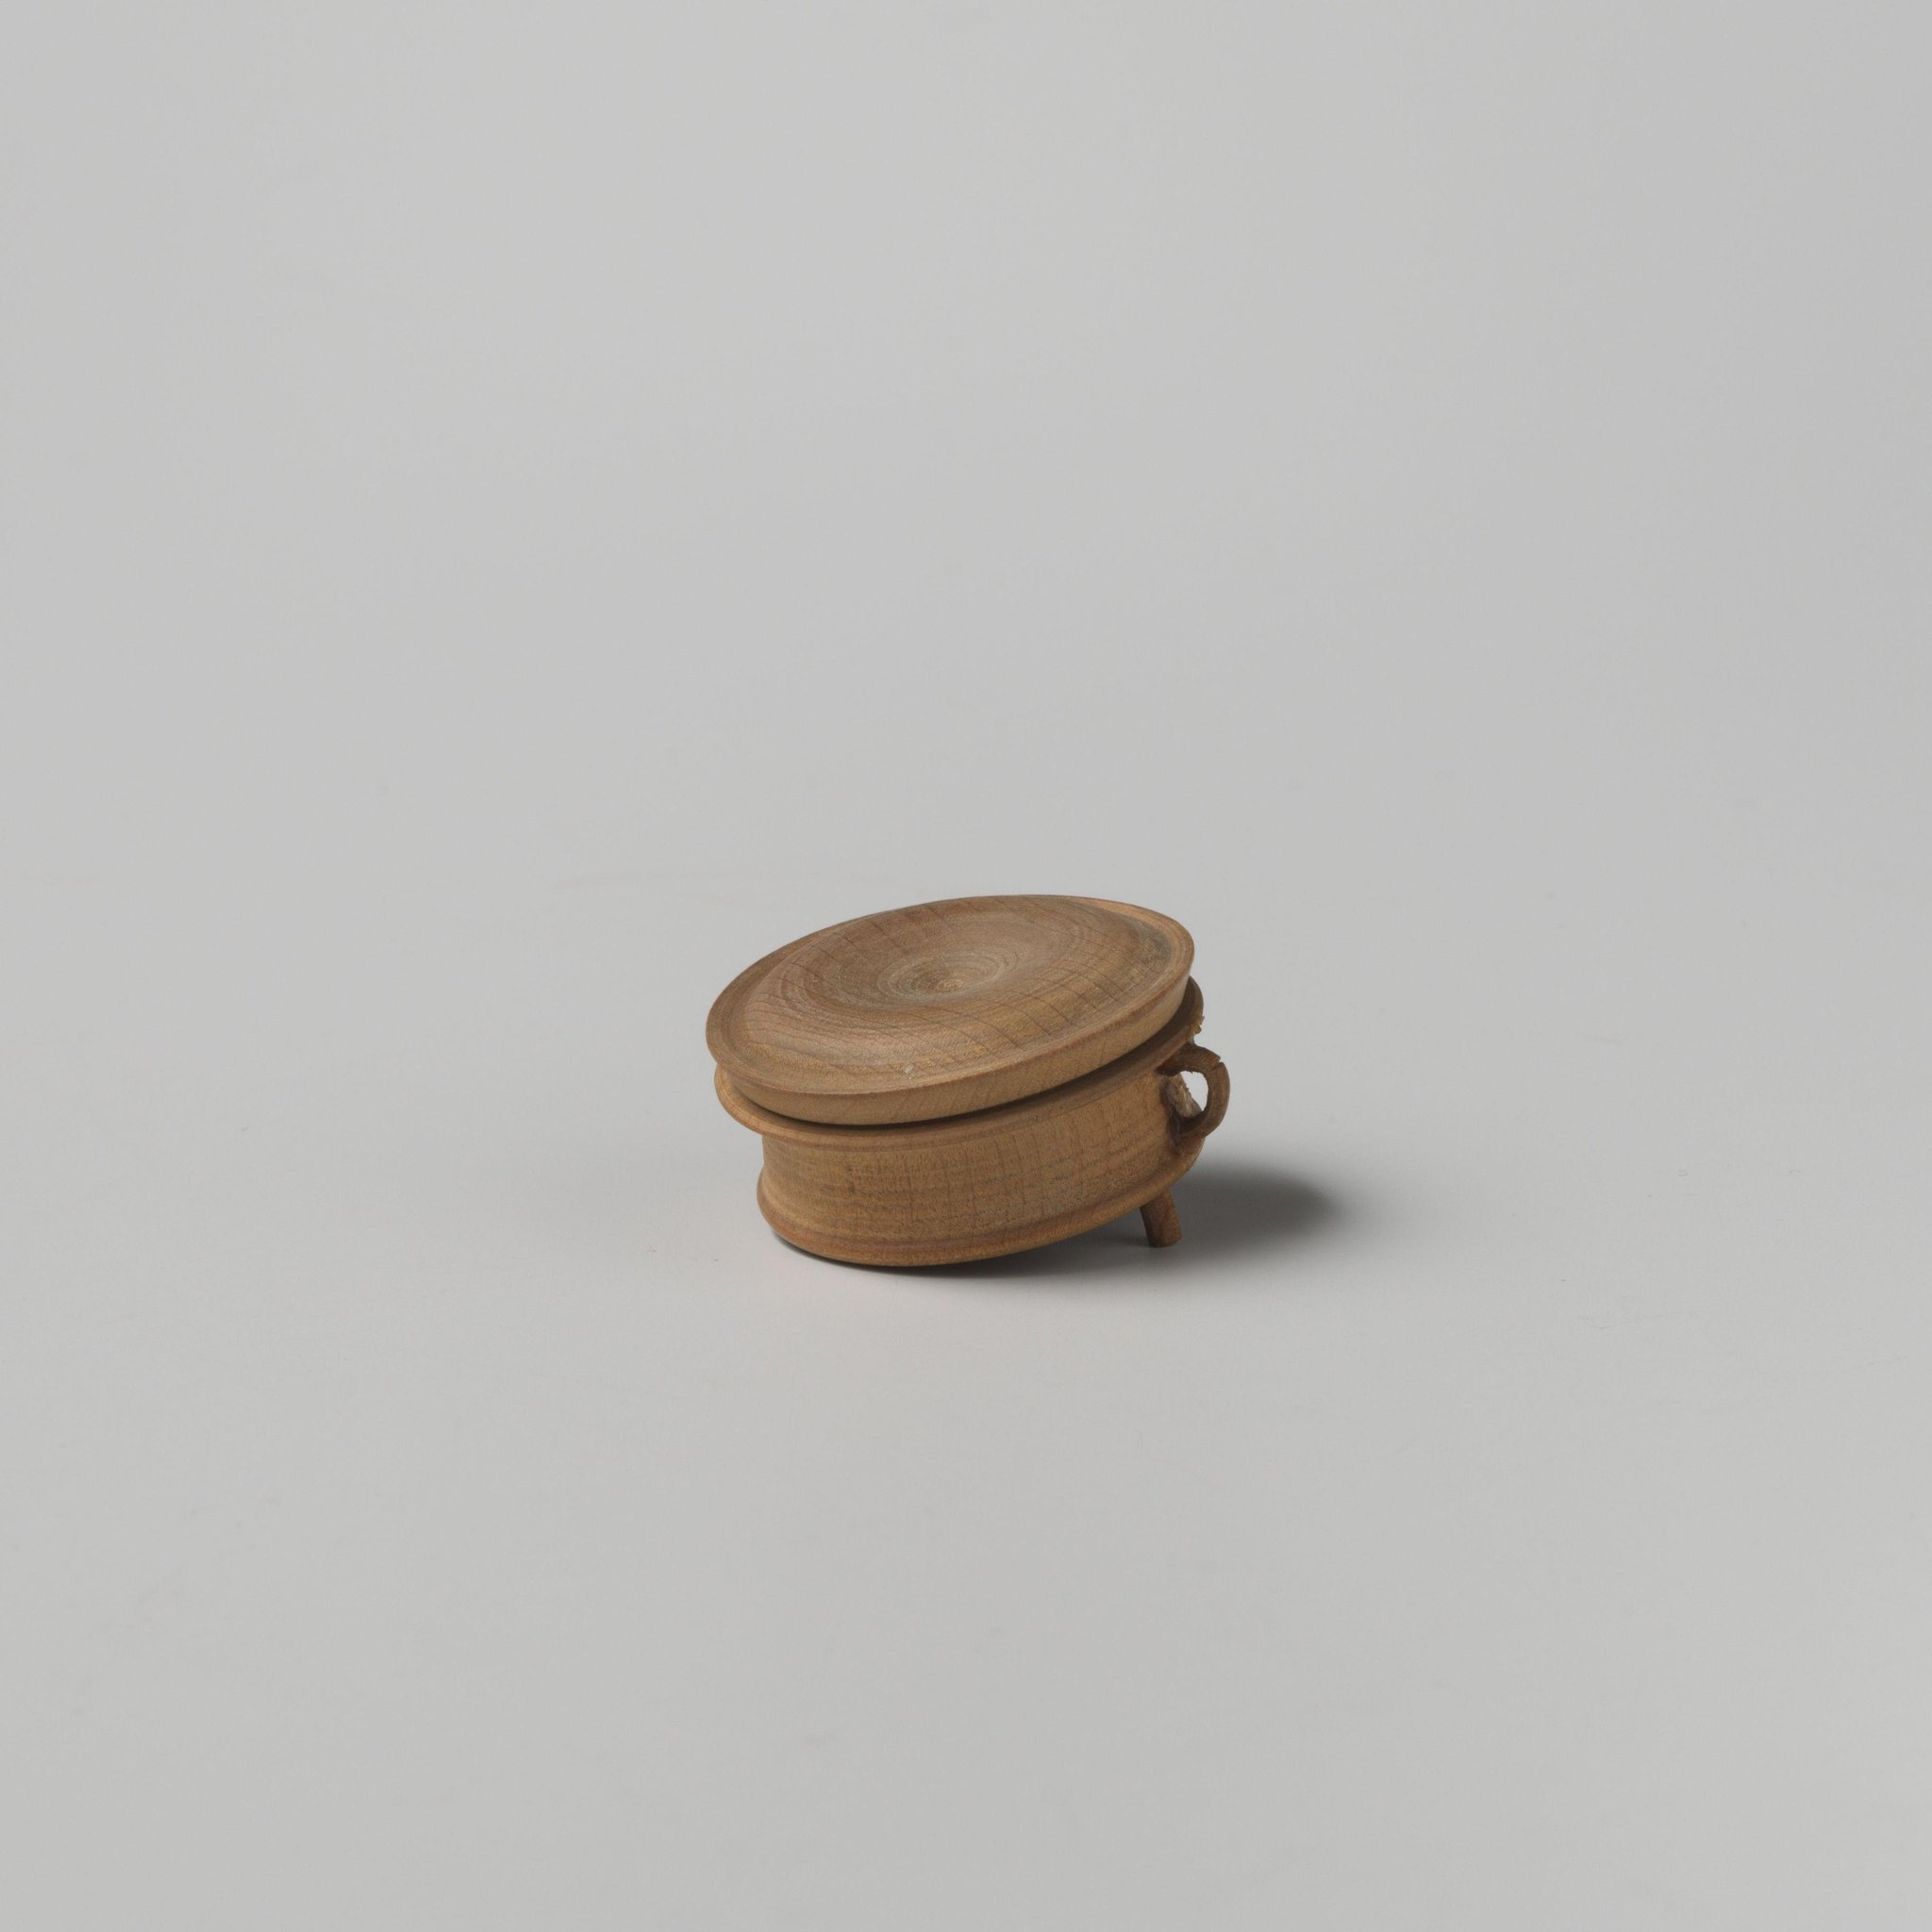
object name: pot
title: Pot met deksel, gedraaid van esdoornhout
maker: Anonymous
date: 1675-1699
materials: wood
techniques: turning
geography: amsterdam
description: Pot met deksel, gedraaid van esdoornhout, met ringversiering. De pot staat op drie poten en heeft twee aangezette handvatten. Het bolle deksel is in het midden verdiept.